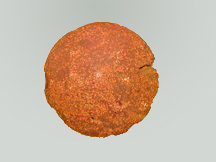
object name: disk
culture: italic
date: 700-401 BCE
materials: amber